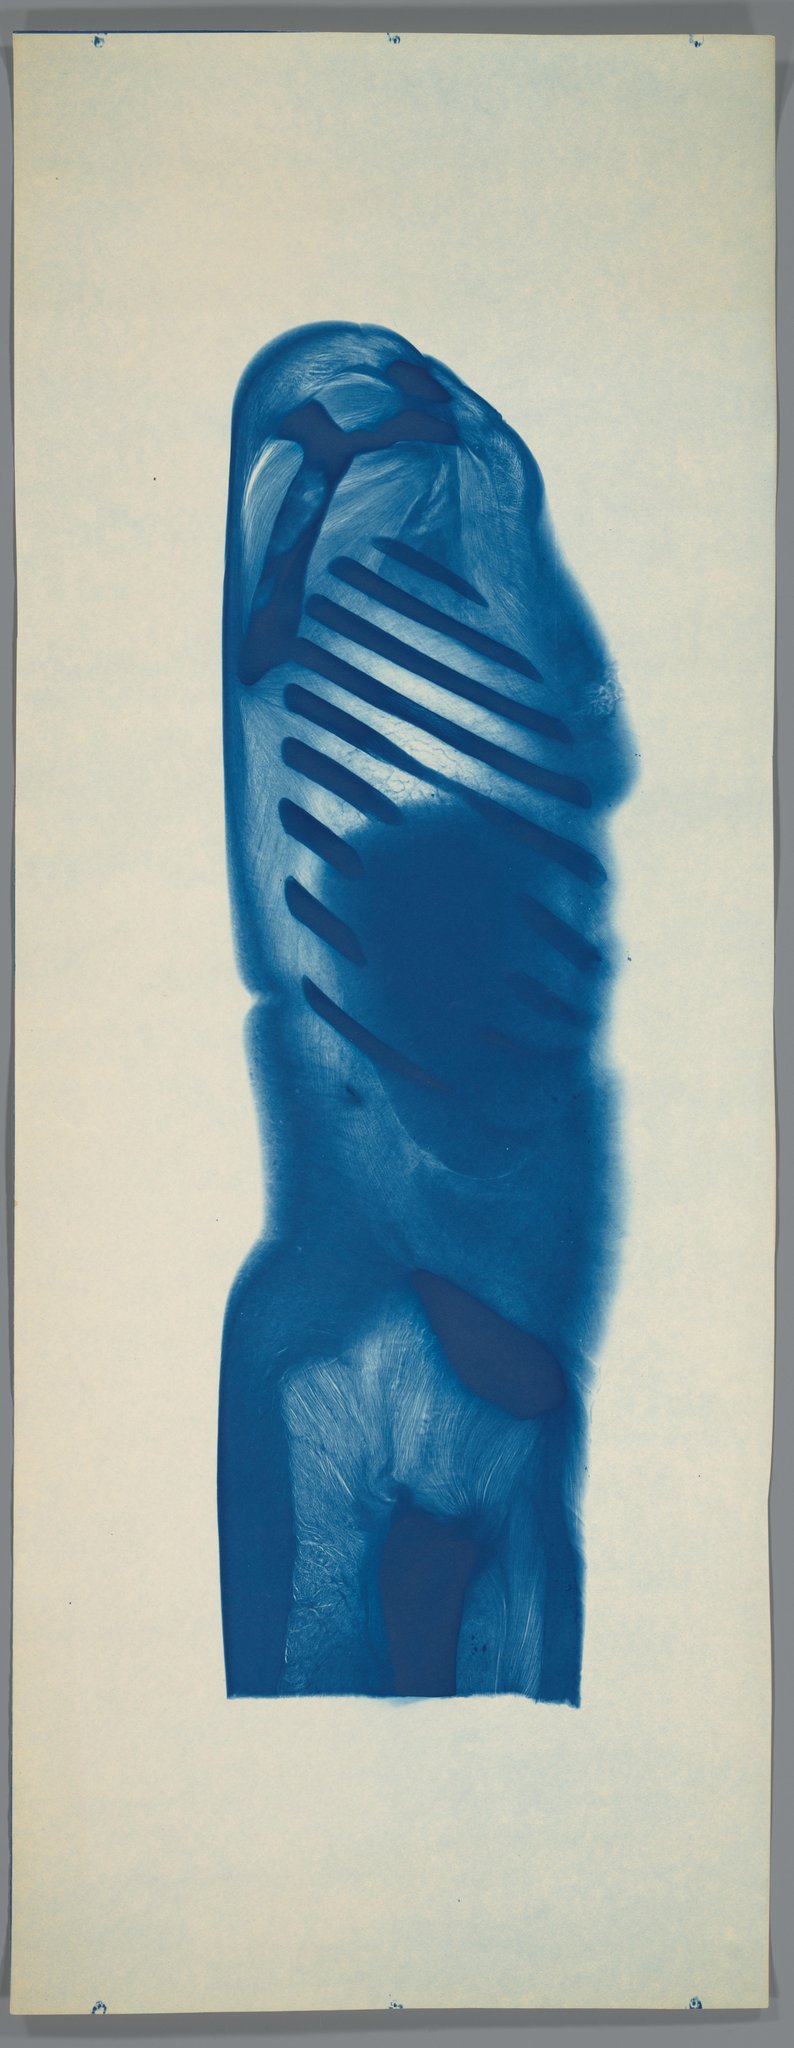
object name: photograph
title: Radiographic views of a sagittal sectioned human body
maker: harold o. mahoney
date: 1941-1949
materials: photographic support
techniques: cyanotype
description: Just how bizarre was the project of Mahoney, a radiologic technologist with the American company General Electric and a formally trained artist? In the 1930s, working with Northwestern University near Chicago, he created a technique allowing him to record soft tissue, in addition to bones, with X-rays. His team sectioned frozen bodies and made life-sized recordings of them. Only recently has it become clear that the (mostly African-American) cadavers, the ‘unclaimed bodies,’ came from the slums of Chicago.